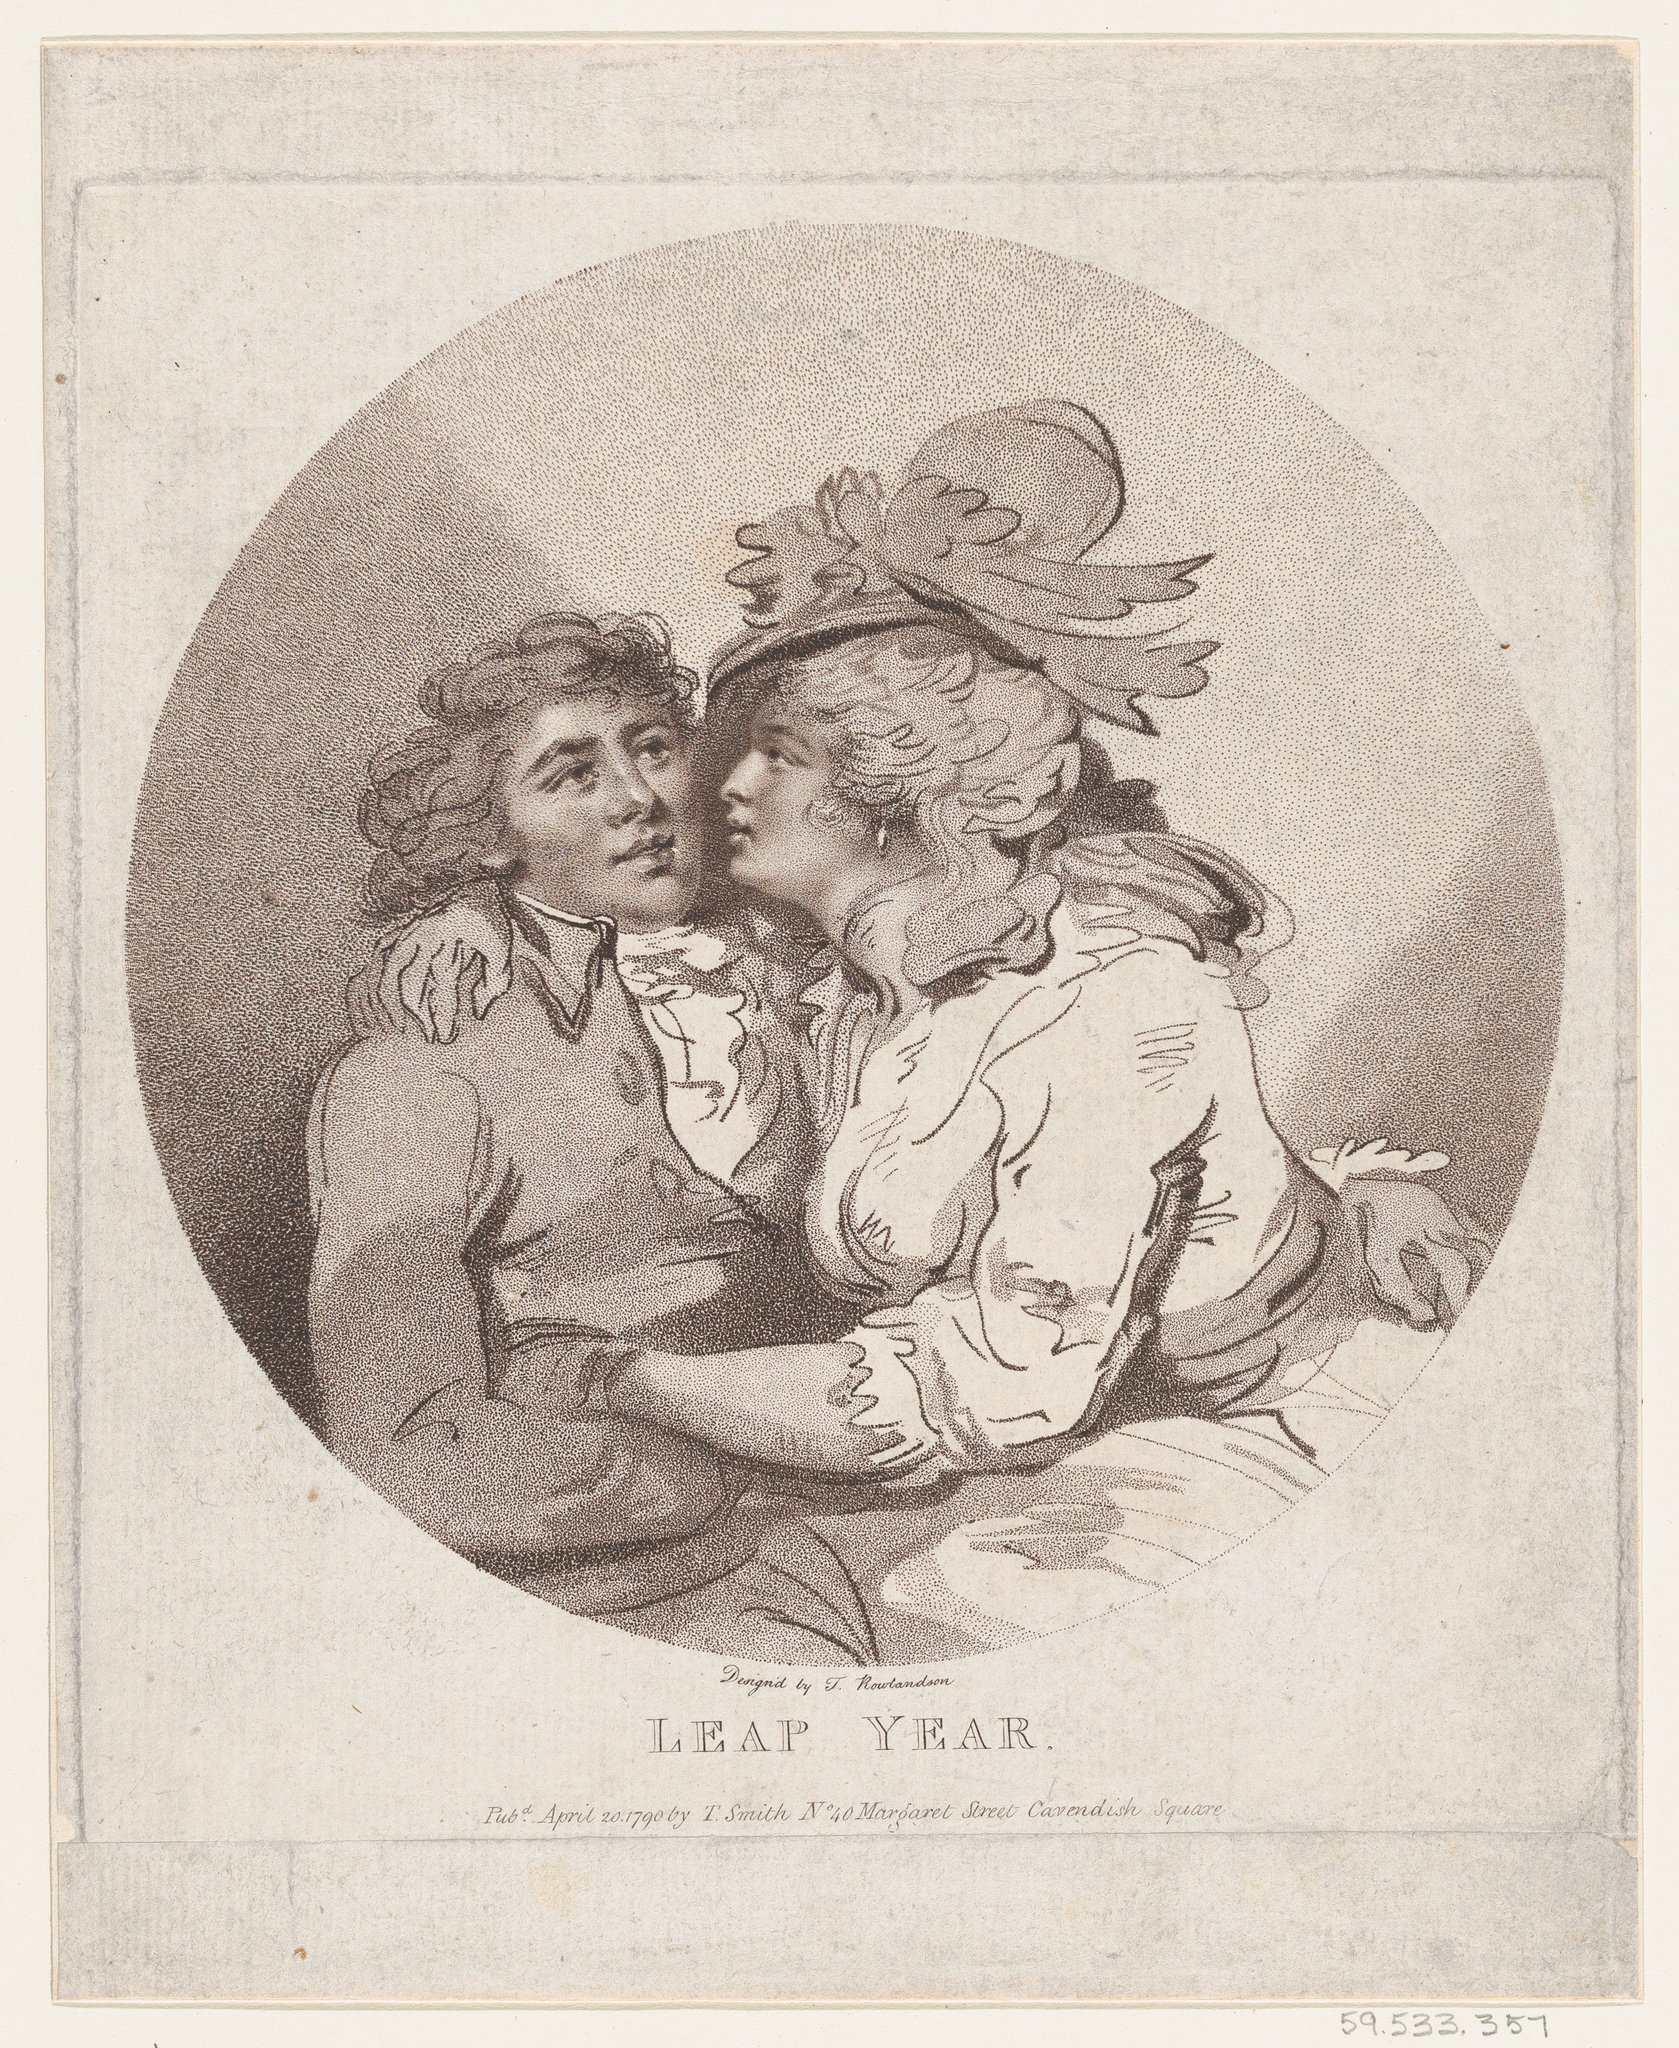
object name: print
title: Leap Year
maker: t. smith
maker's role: etcher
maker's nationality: british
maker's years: 1785-1787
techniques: aquatint, etching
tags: men,women